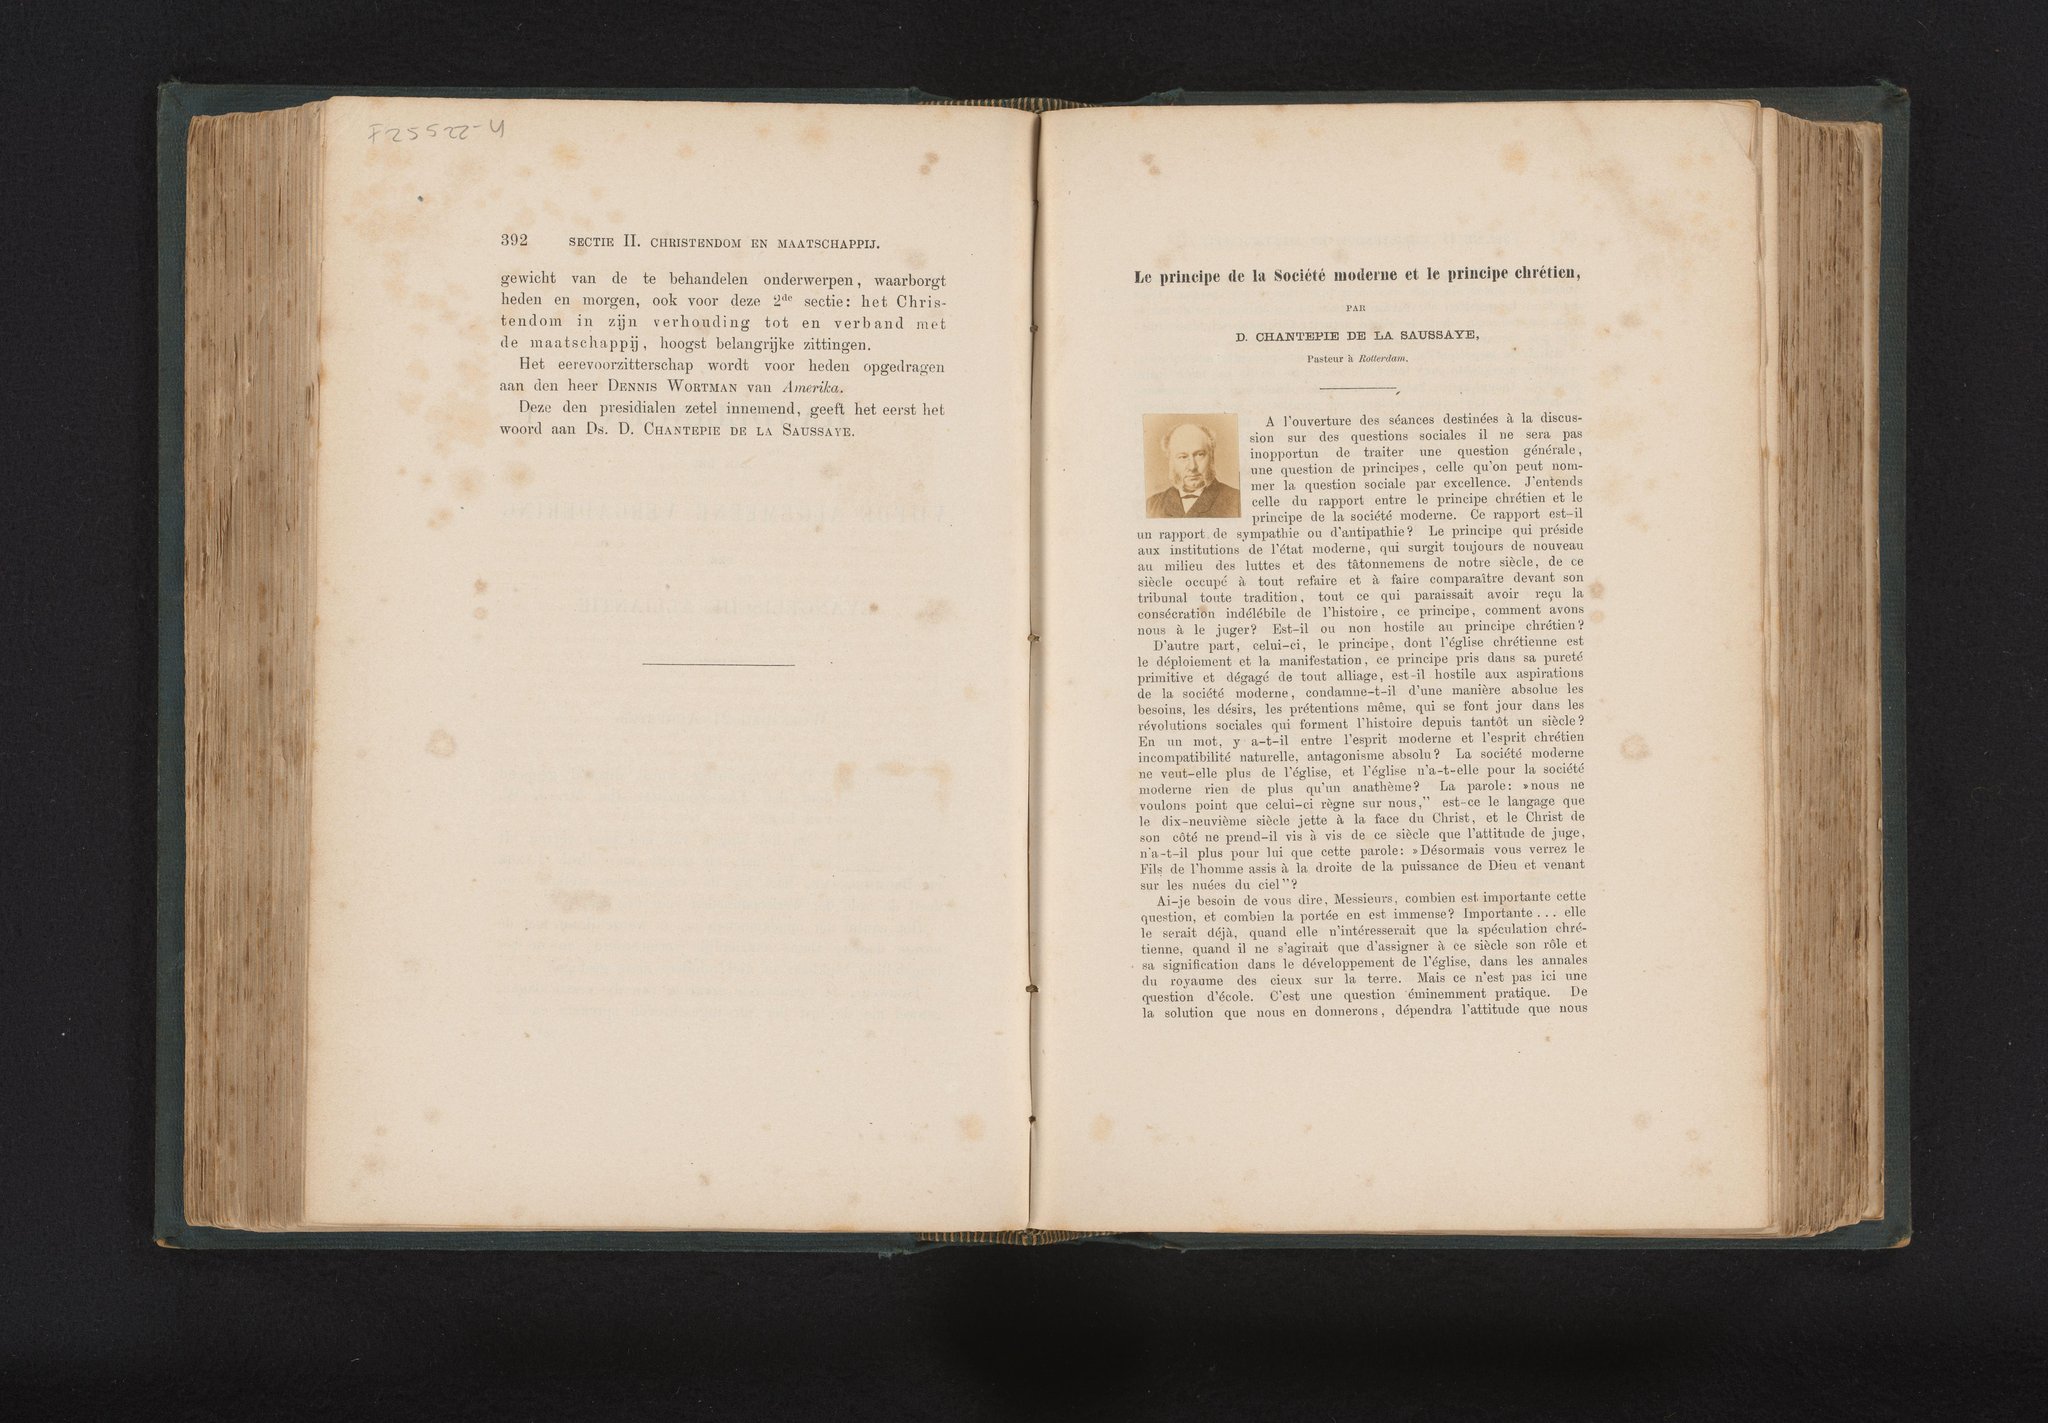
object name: page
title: Portret van Daniël Chantepie de la Saussaye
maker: Anonymous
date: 1855-1867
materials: paper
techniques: albumen print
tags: the hague, historical persons